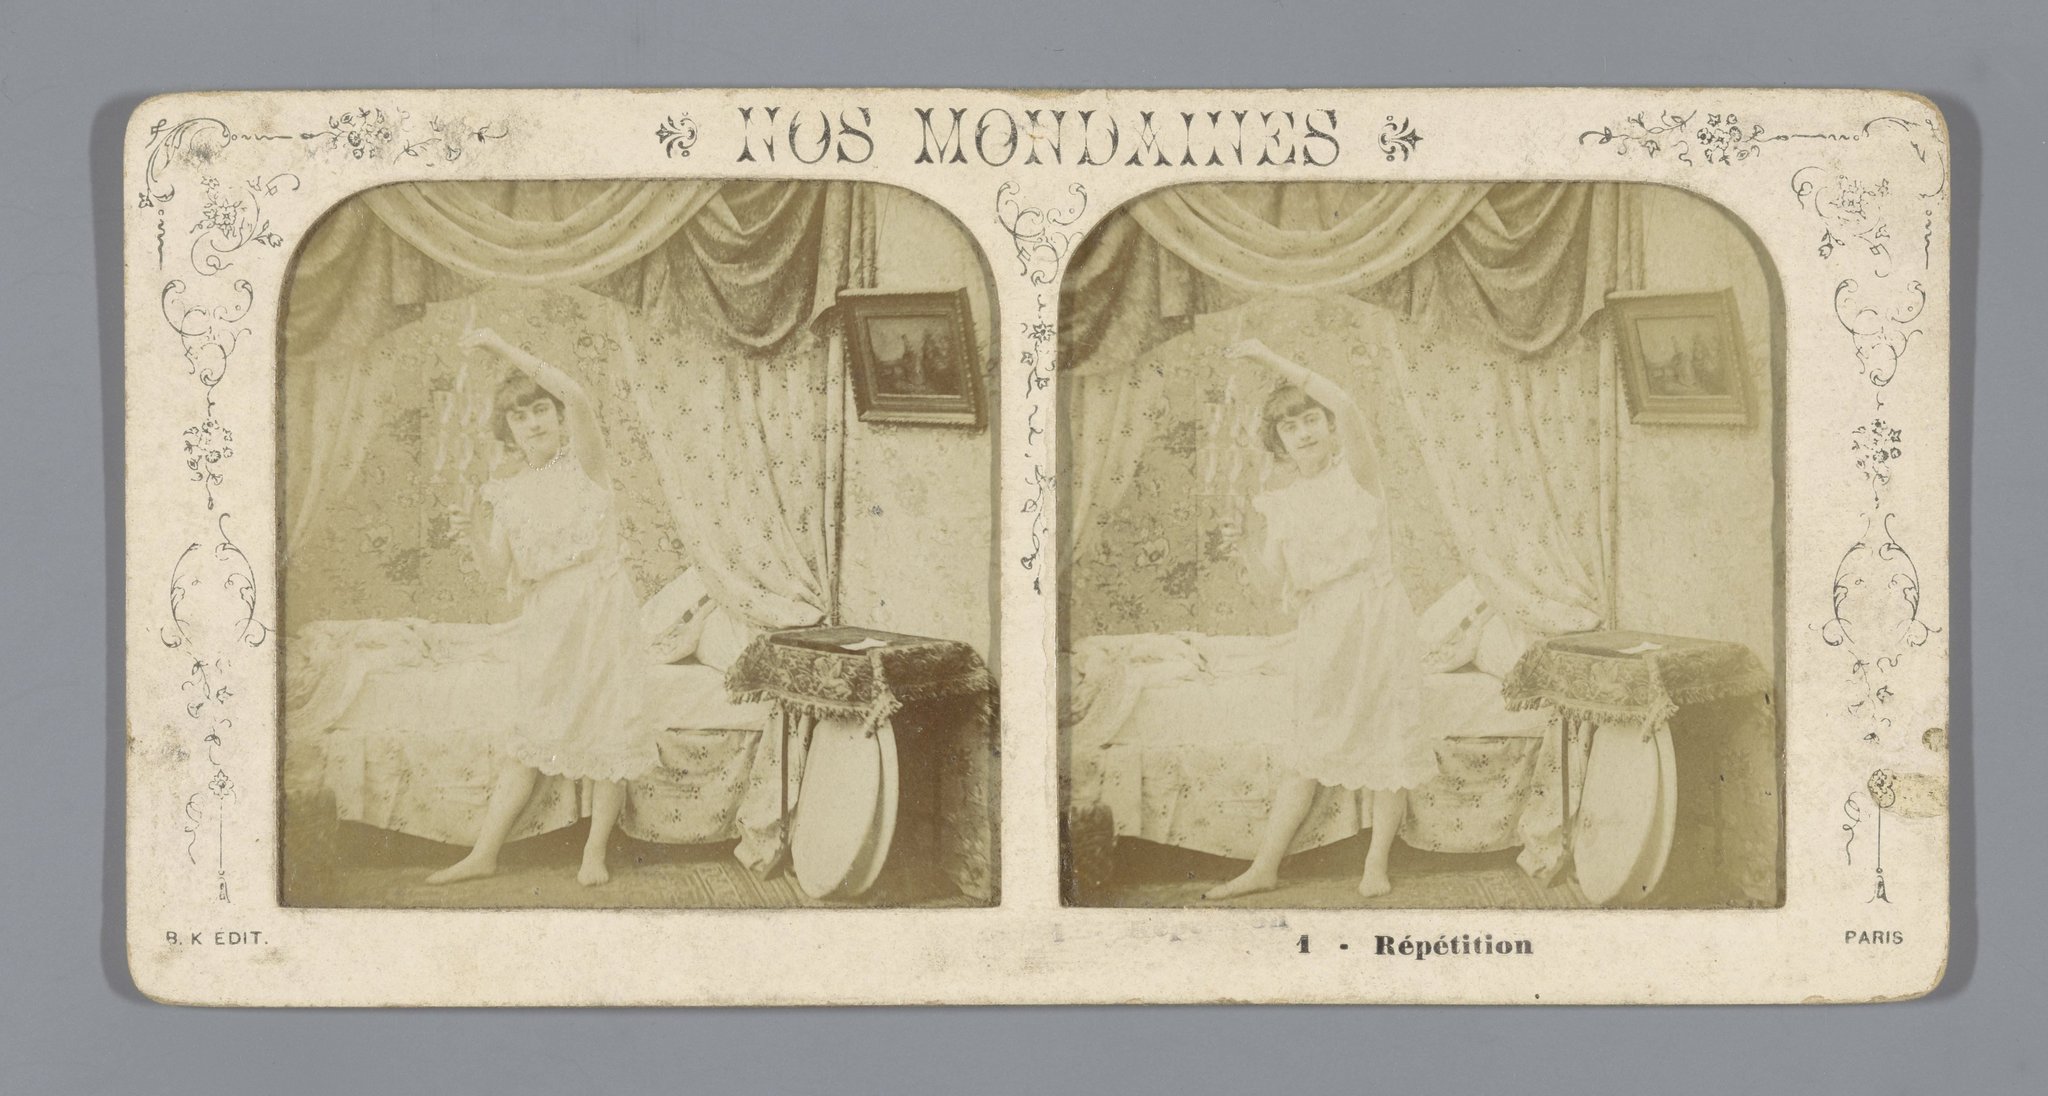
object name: tissue stereograph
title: Répétition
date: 1863-1875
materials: cardboard, paper, photographic support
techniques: albumen print, cutting, hand coloring, perforating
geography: paris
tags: braiding, france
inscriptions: number: ‘1’